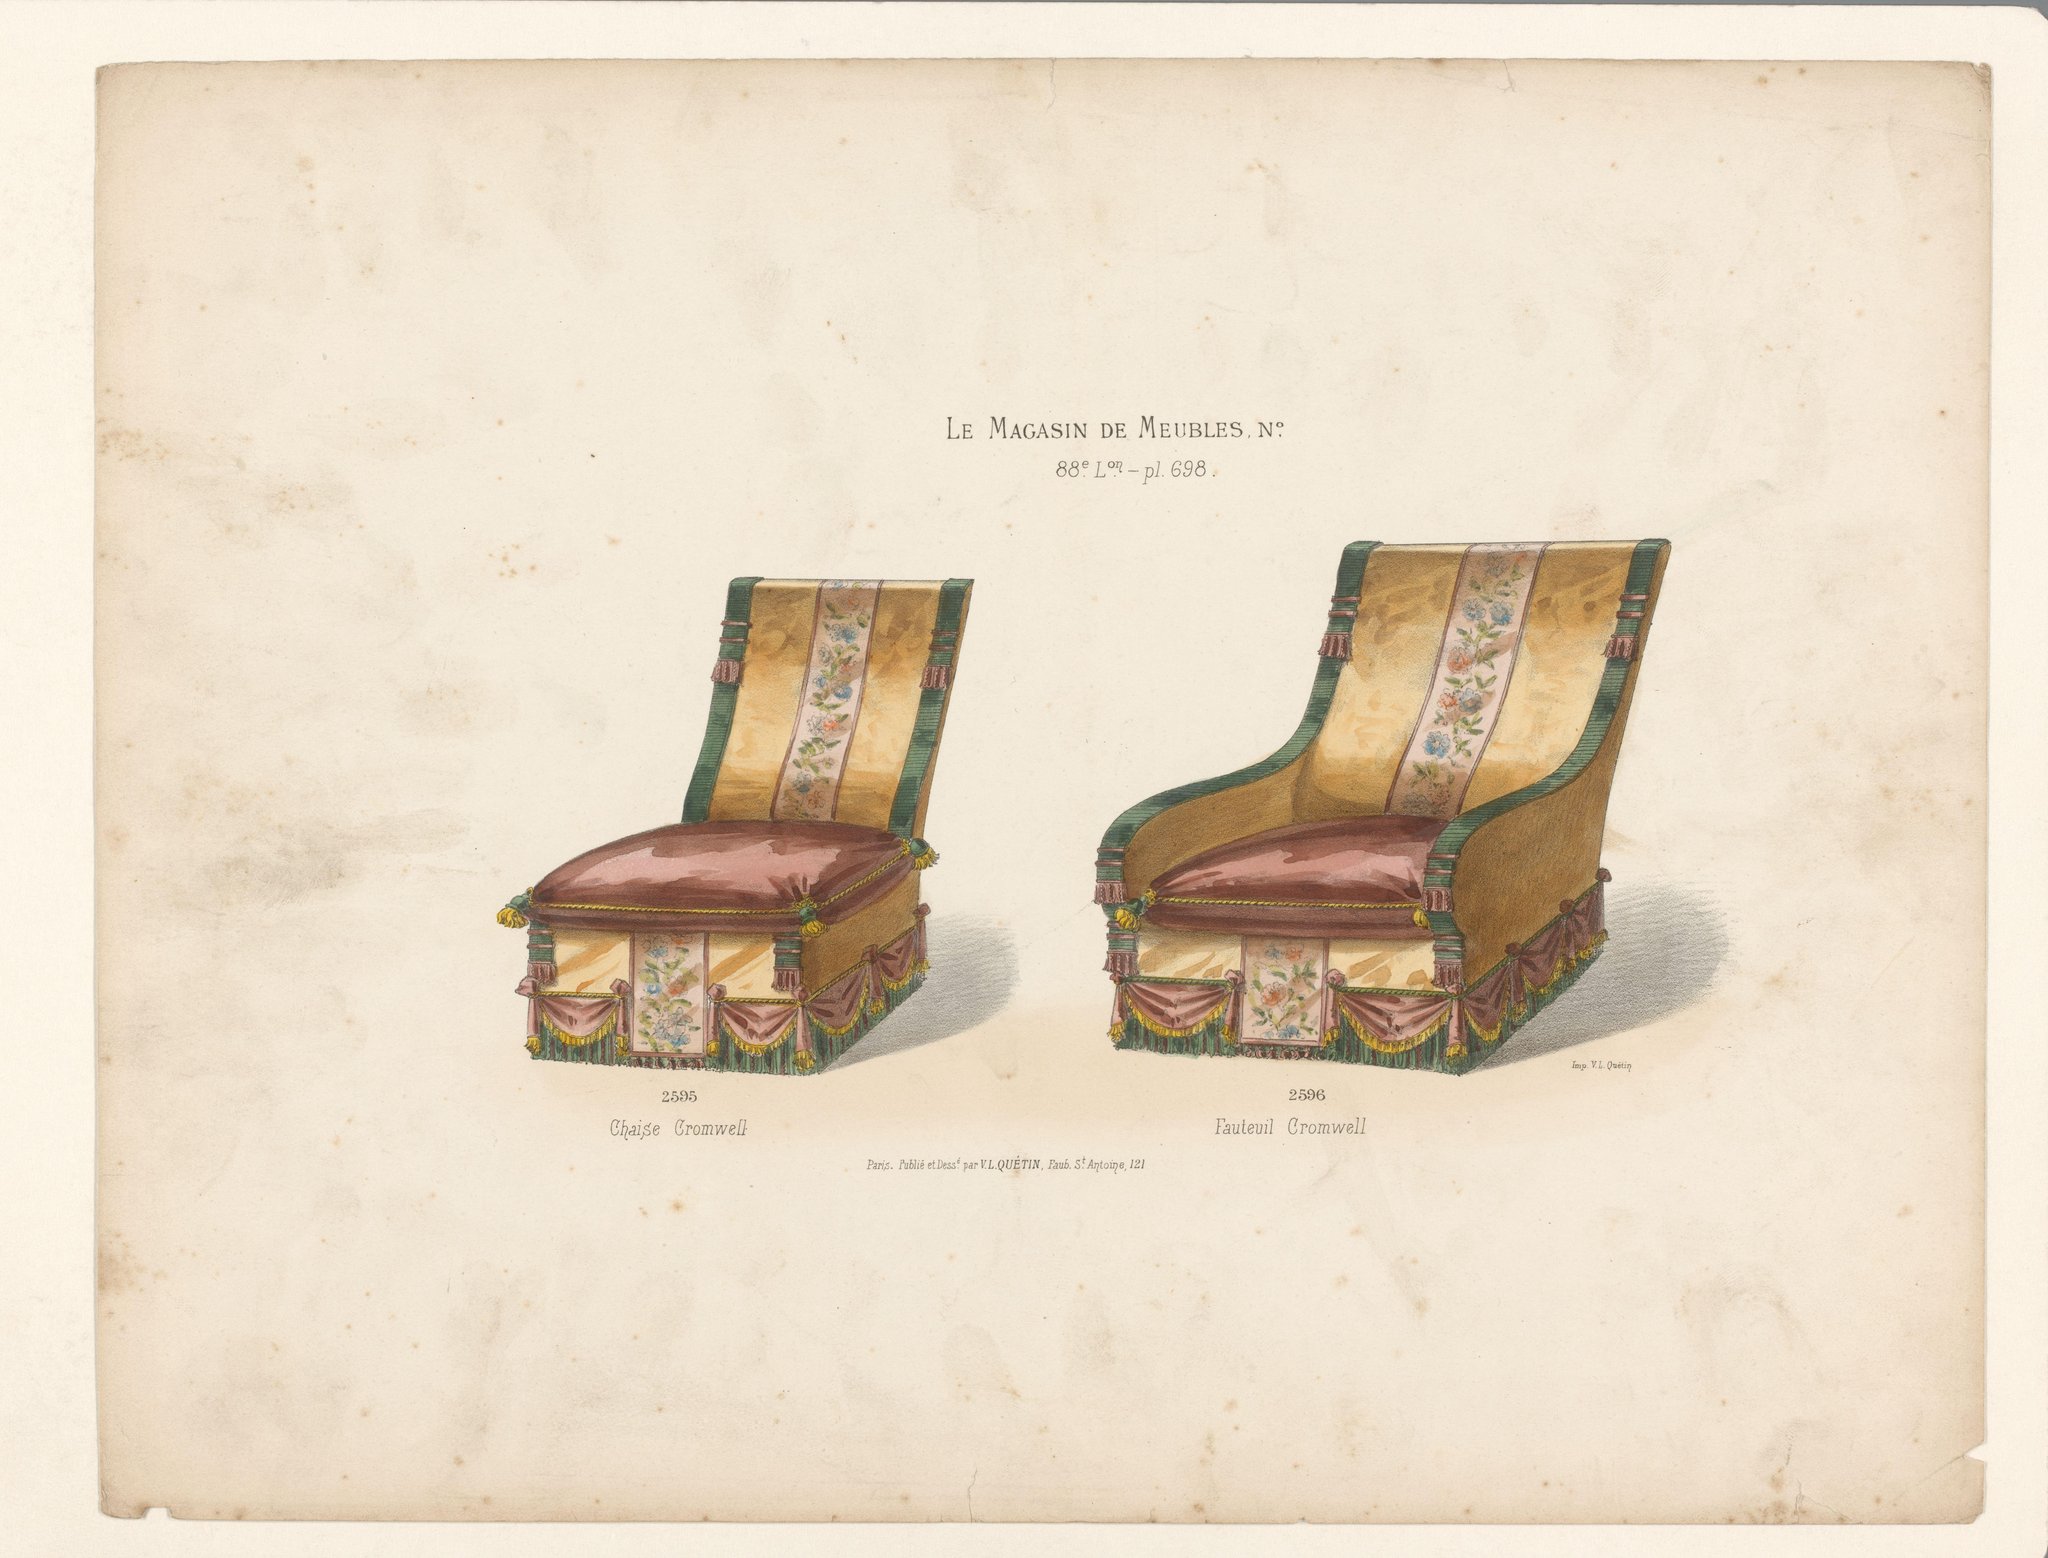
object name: print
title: Le Magasin de Meubles / No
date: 1878-1904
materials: paper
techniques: hand coloring, lithograph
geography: paris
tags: seating furniture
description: Een stoel en fauteuil. Prent uit 88e Livraison.